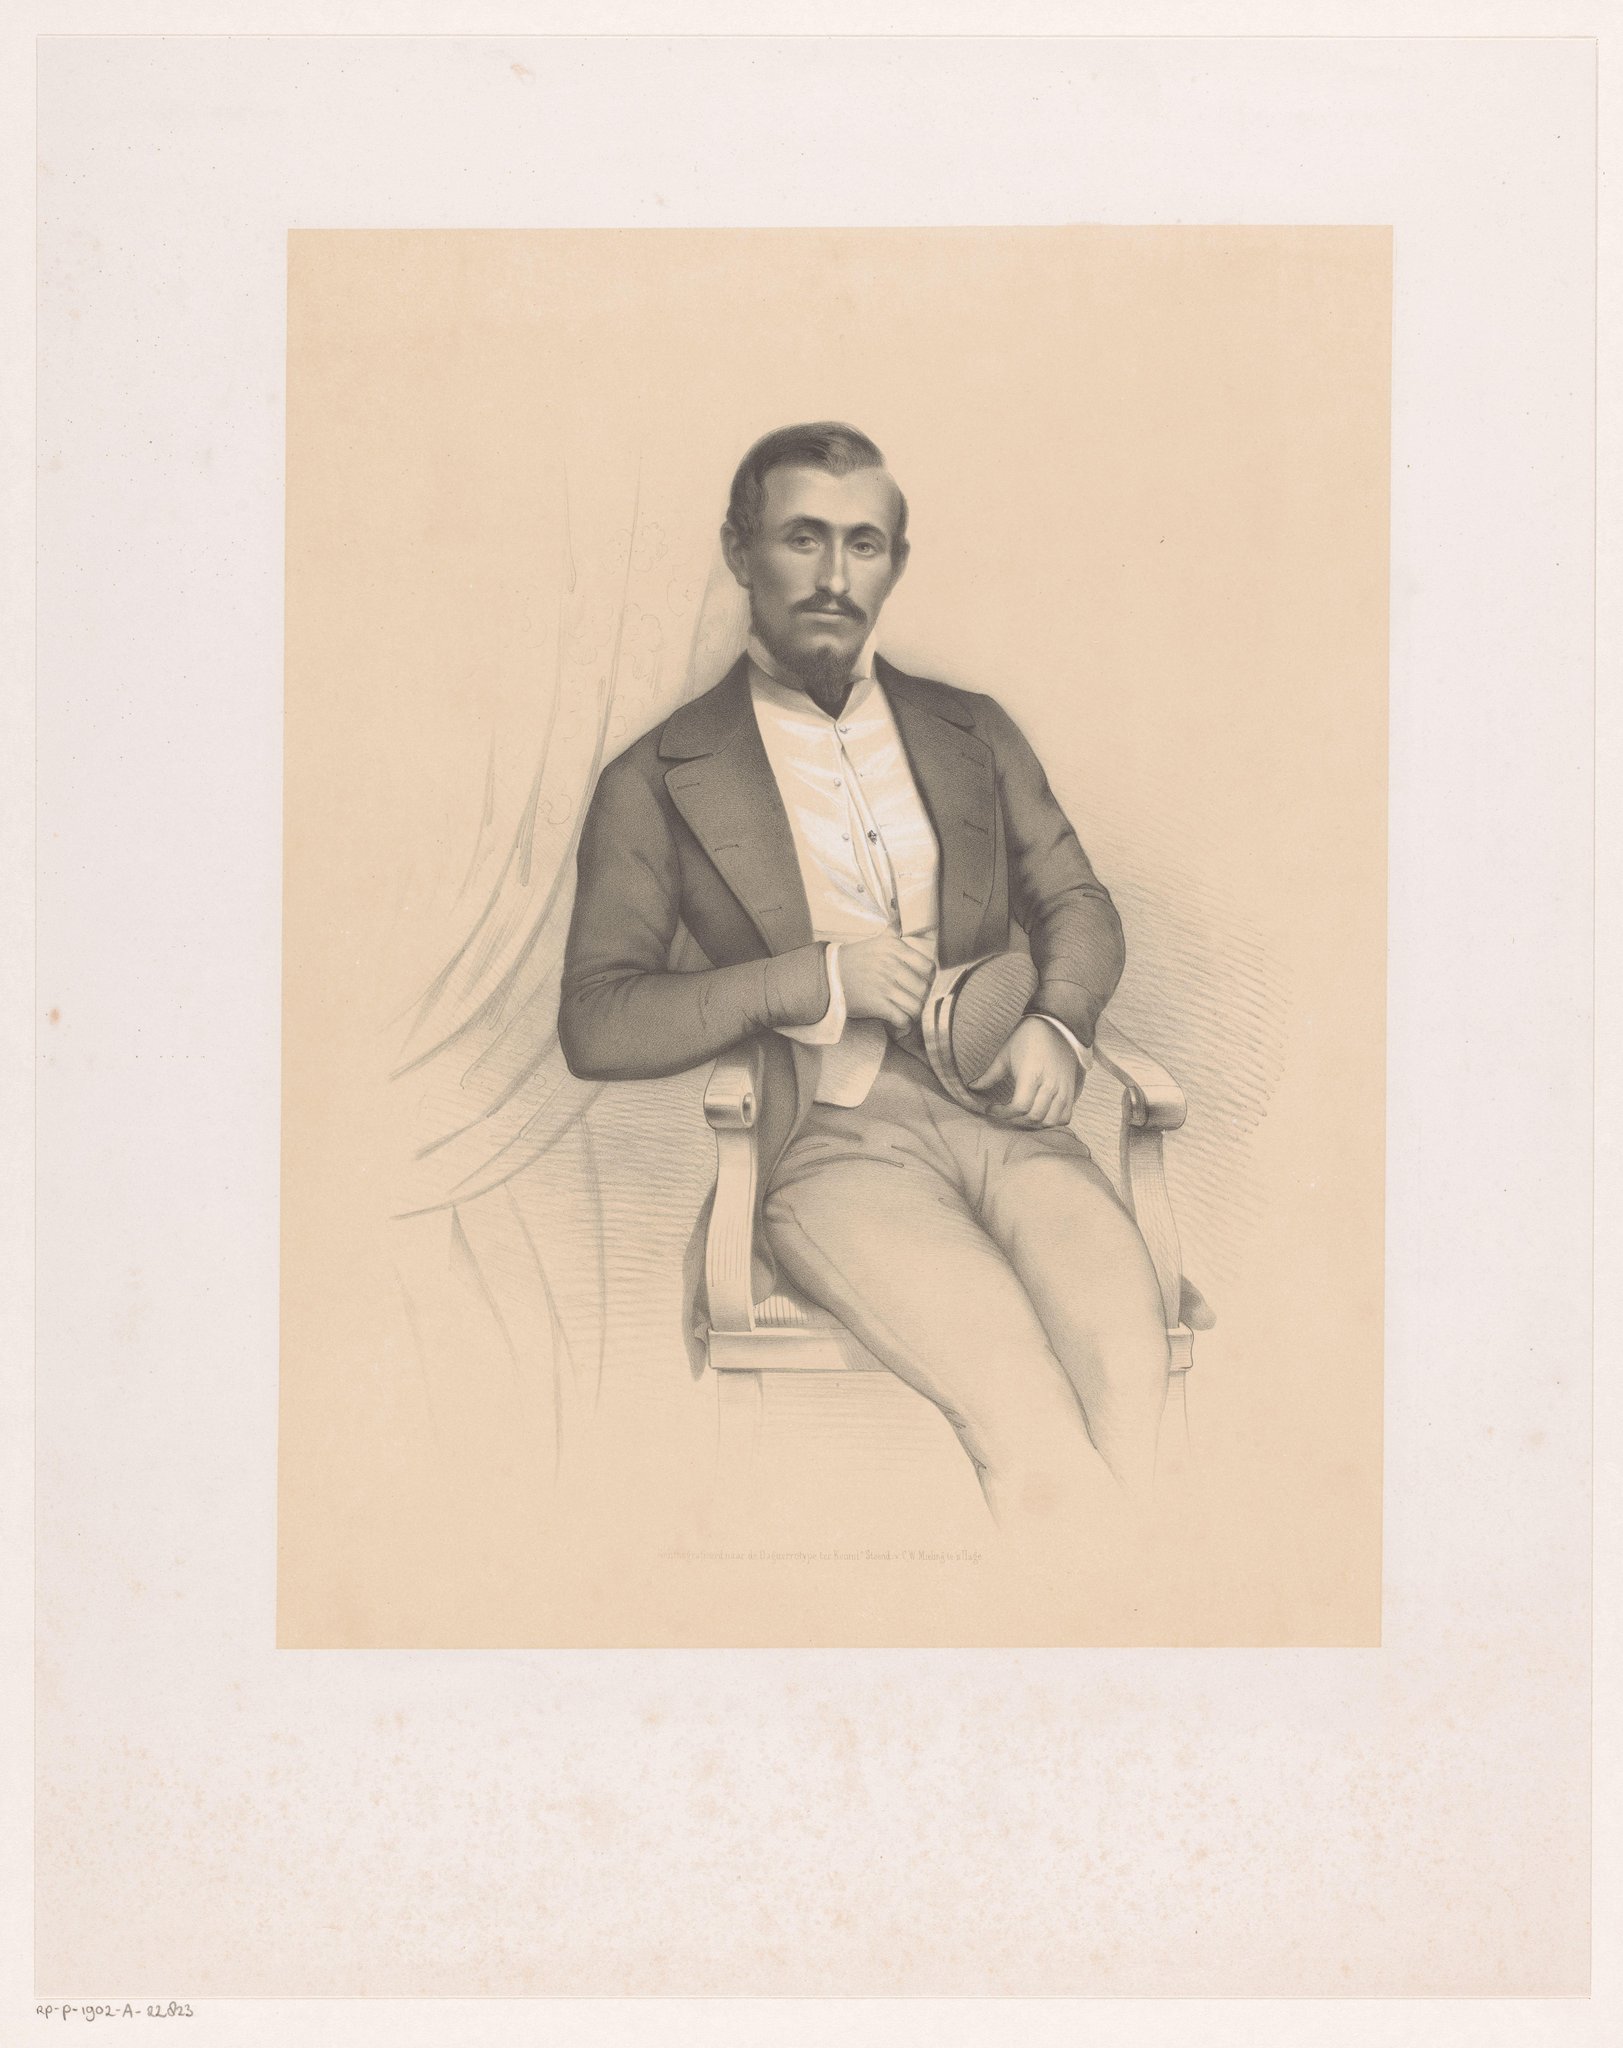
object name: print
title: Portret van een Indische ambtenaar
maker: Anonymous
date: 1847-1865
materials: paper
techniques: tone lithography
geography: the hague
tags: head-gear: cap, historical persons (+ three-quarter length portrait)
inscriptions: collector's mark: Lugt 2228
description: De geportretteerde zit op een stoel met zijn uniformpet in zijn handen.